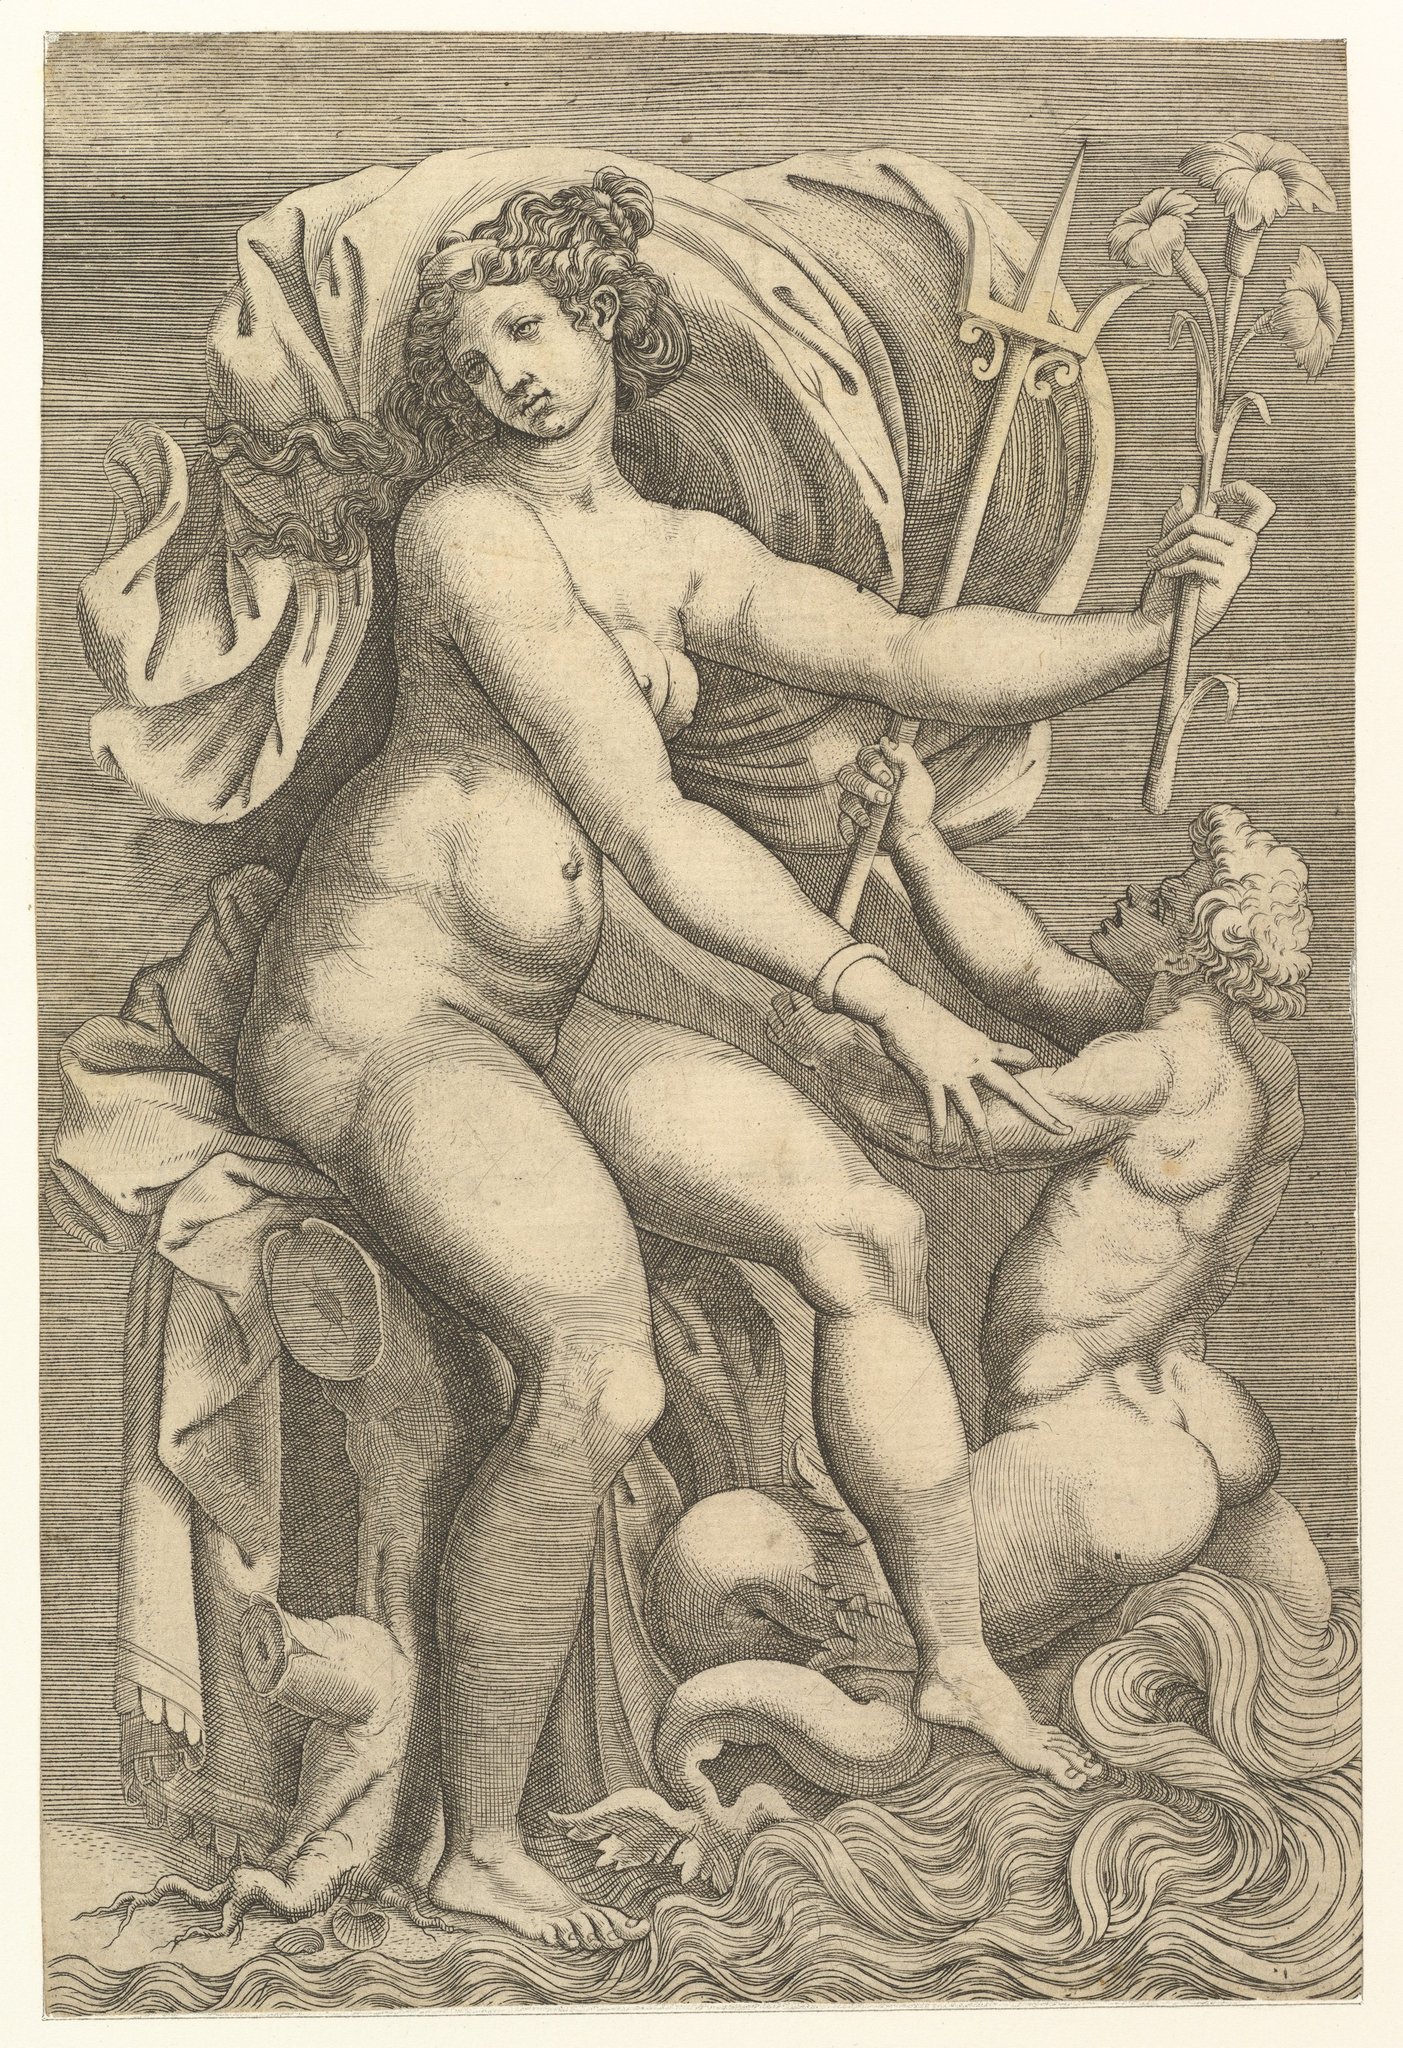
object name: print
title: Thetis Seated with a Triton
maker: anonymous, italian?, 16th century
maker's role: artist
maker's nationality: italian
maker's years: 1500-1600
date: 1501-1600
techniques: engraving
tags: triton,goddess